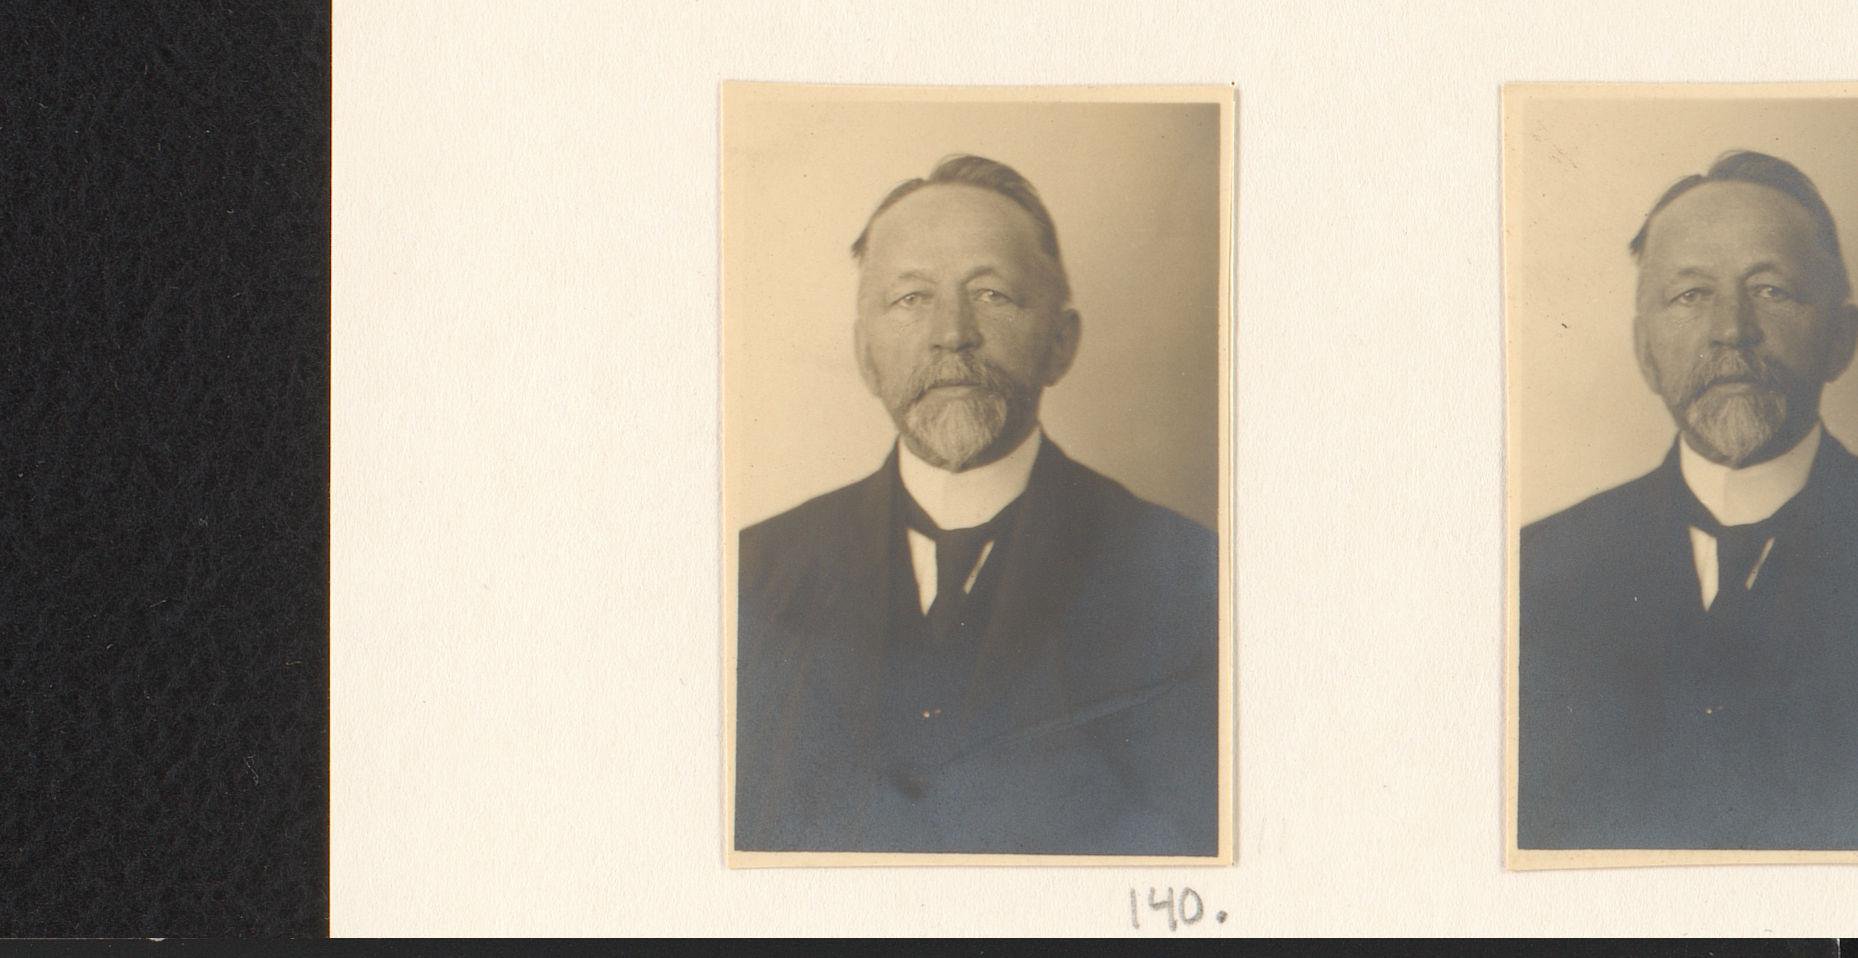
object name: photograph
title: Andries Bonger op middelbare leeftijd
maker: Anonymous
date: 1930-1936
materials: cardboard, paper, photographic support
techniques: gelatin silver print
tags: amsterdam, andries bonger, historical persons